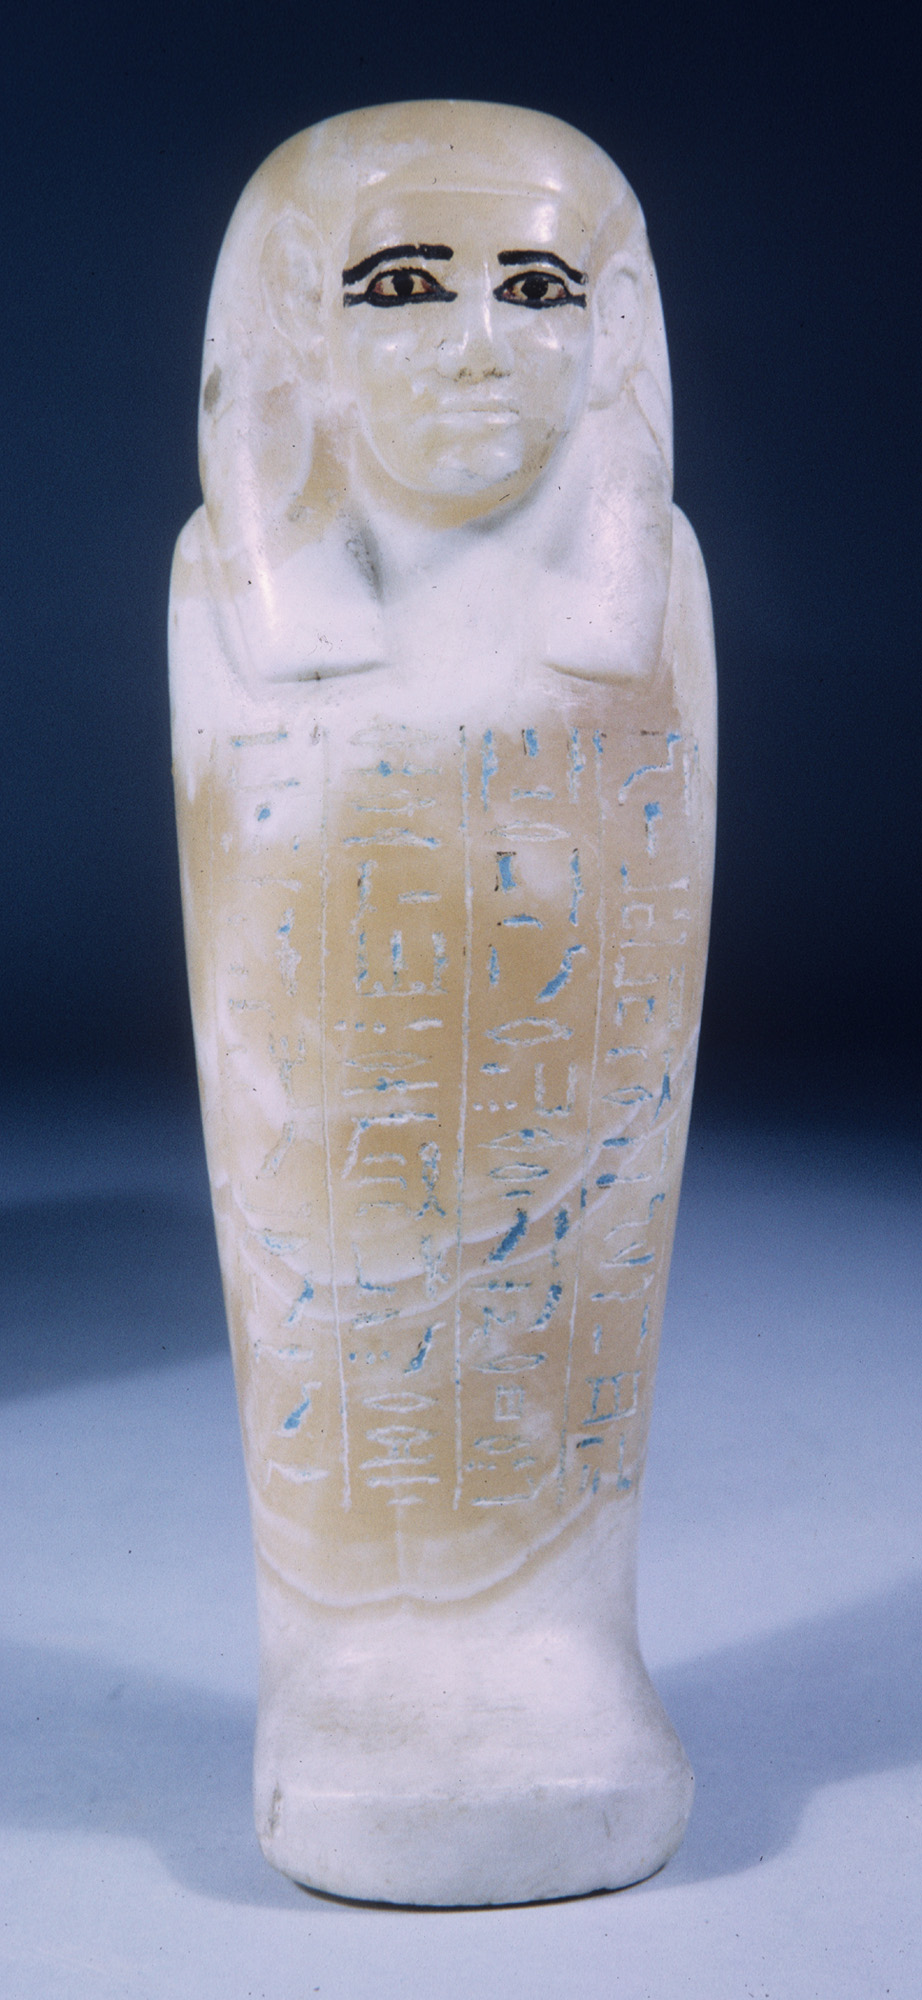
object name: shabti, bener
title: Shabti of Bener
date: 1850-1775 BCE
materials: paint, stone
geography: egypt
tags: hieroglyphs